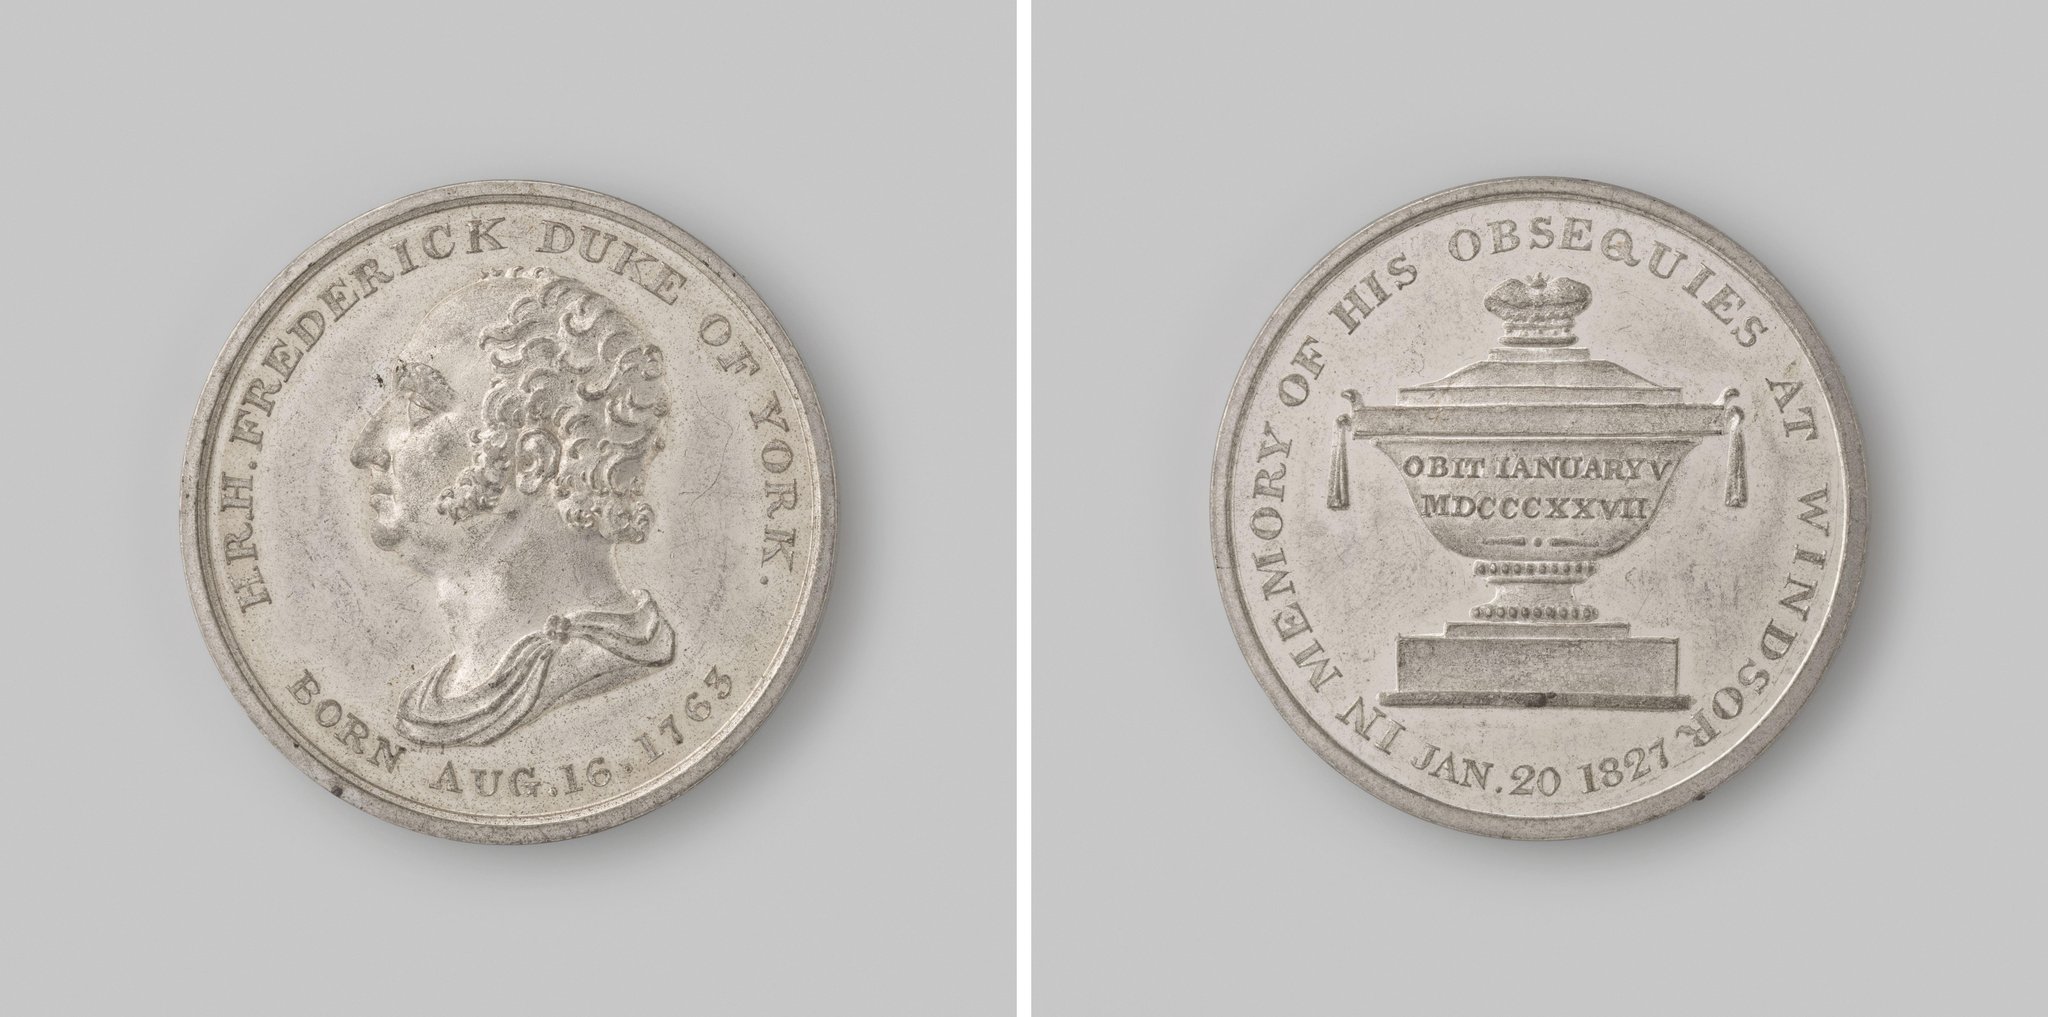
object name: history medal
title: Overlijden van Hertog Frederick van York 1827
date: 1827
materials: tin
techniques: striking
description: Tinnen penning, op de voorzijde het borstbeeld van Frederick naar links met omschrift, op de keerzijde een grafurn met op- en omschrift.